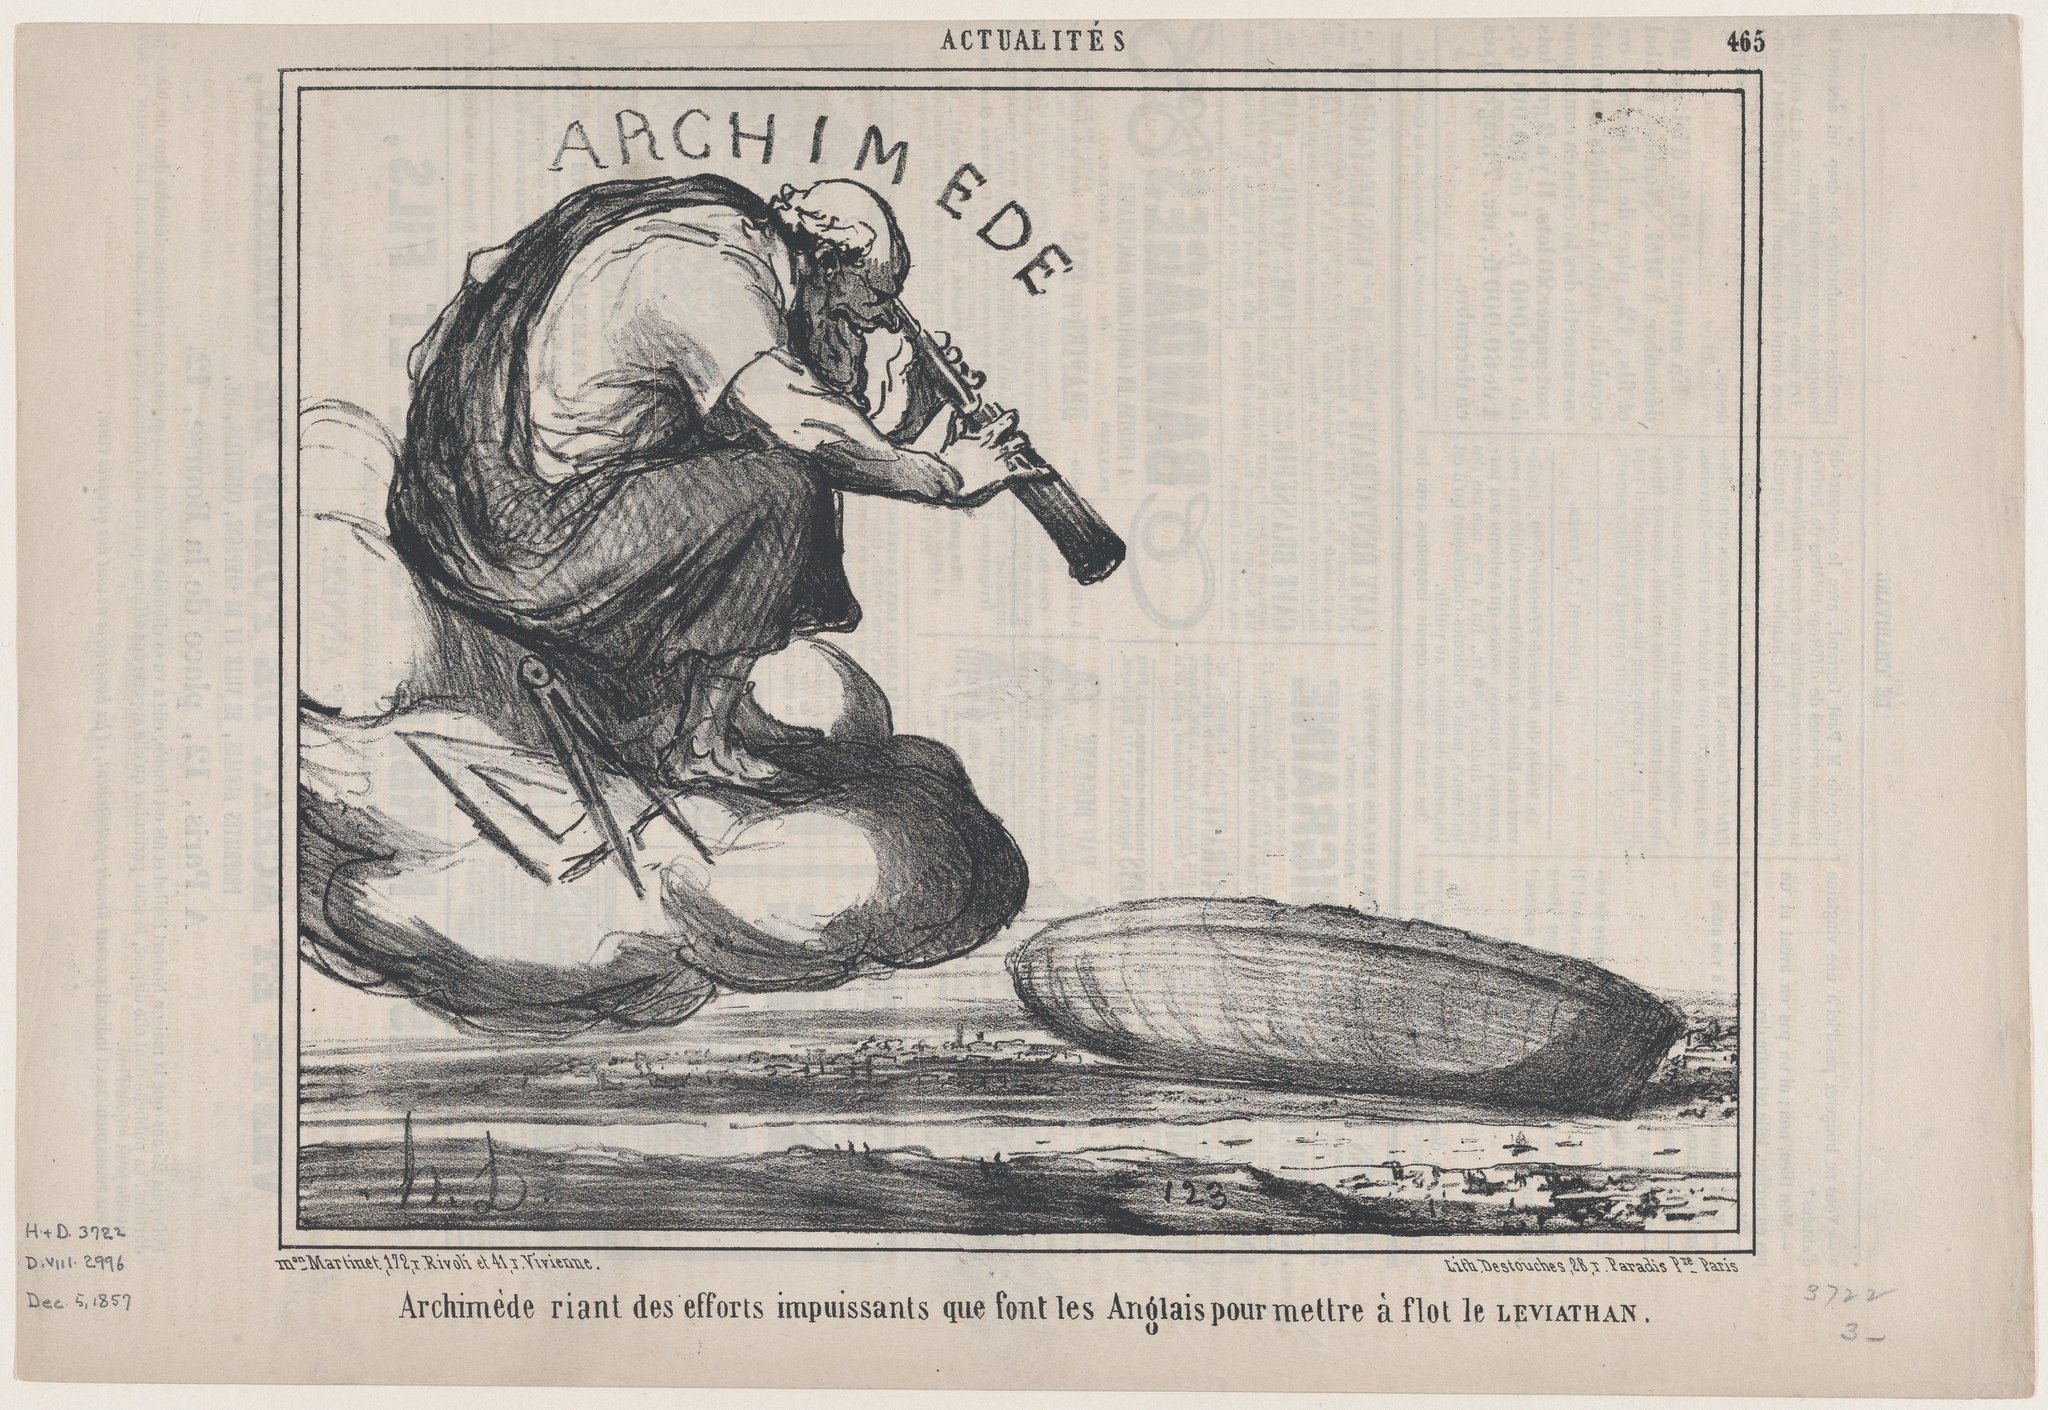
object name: print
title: Archimède riant des efforts impuissants que font les Anglais pour mettre à flot le Leviathan, from "Actualités"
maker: honoré daumier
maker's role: artist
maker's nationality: french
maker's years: 1808-1879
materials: paper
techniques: lithograph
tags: satire,men,telescopes